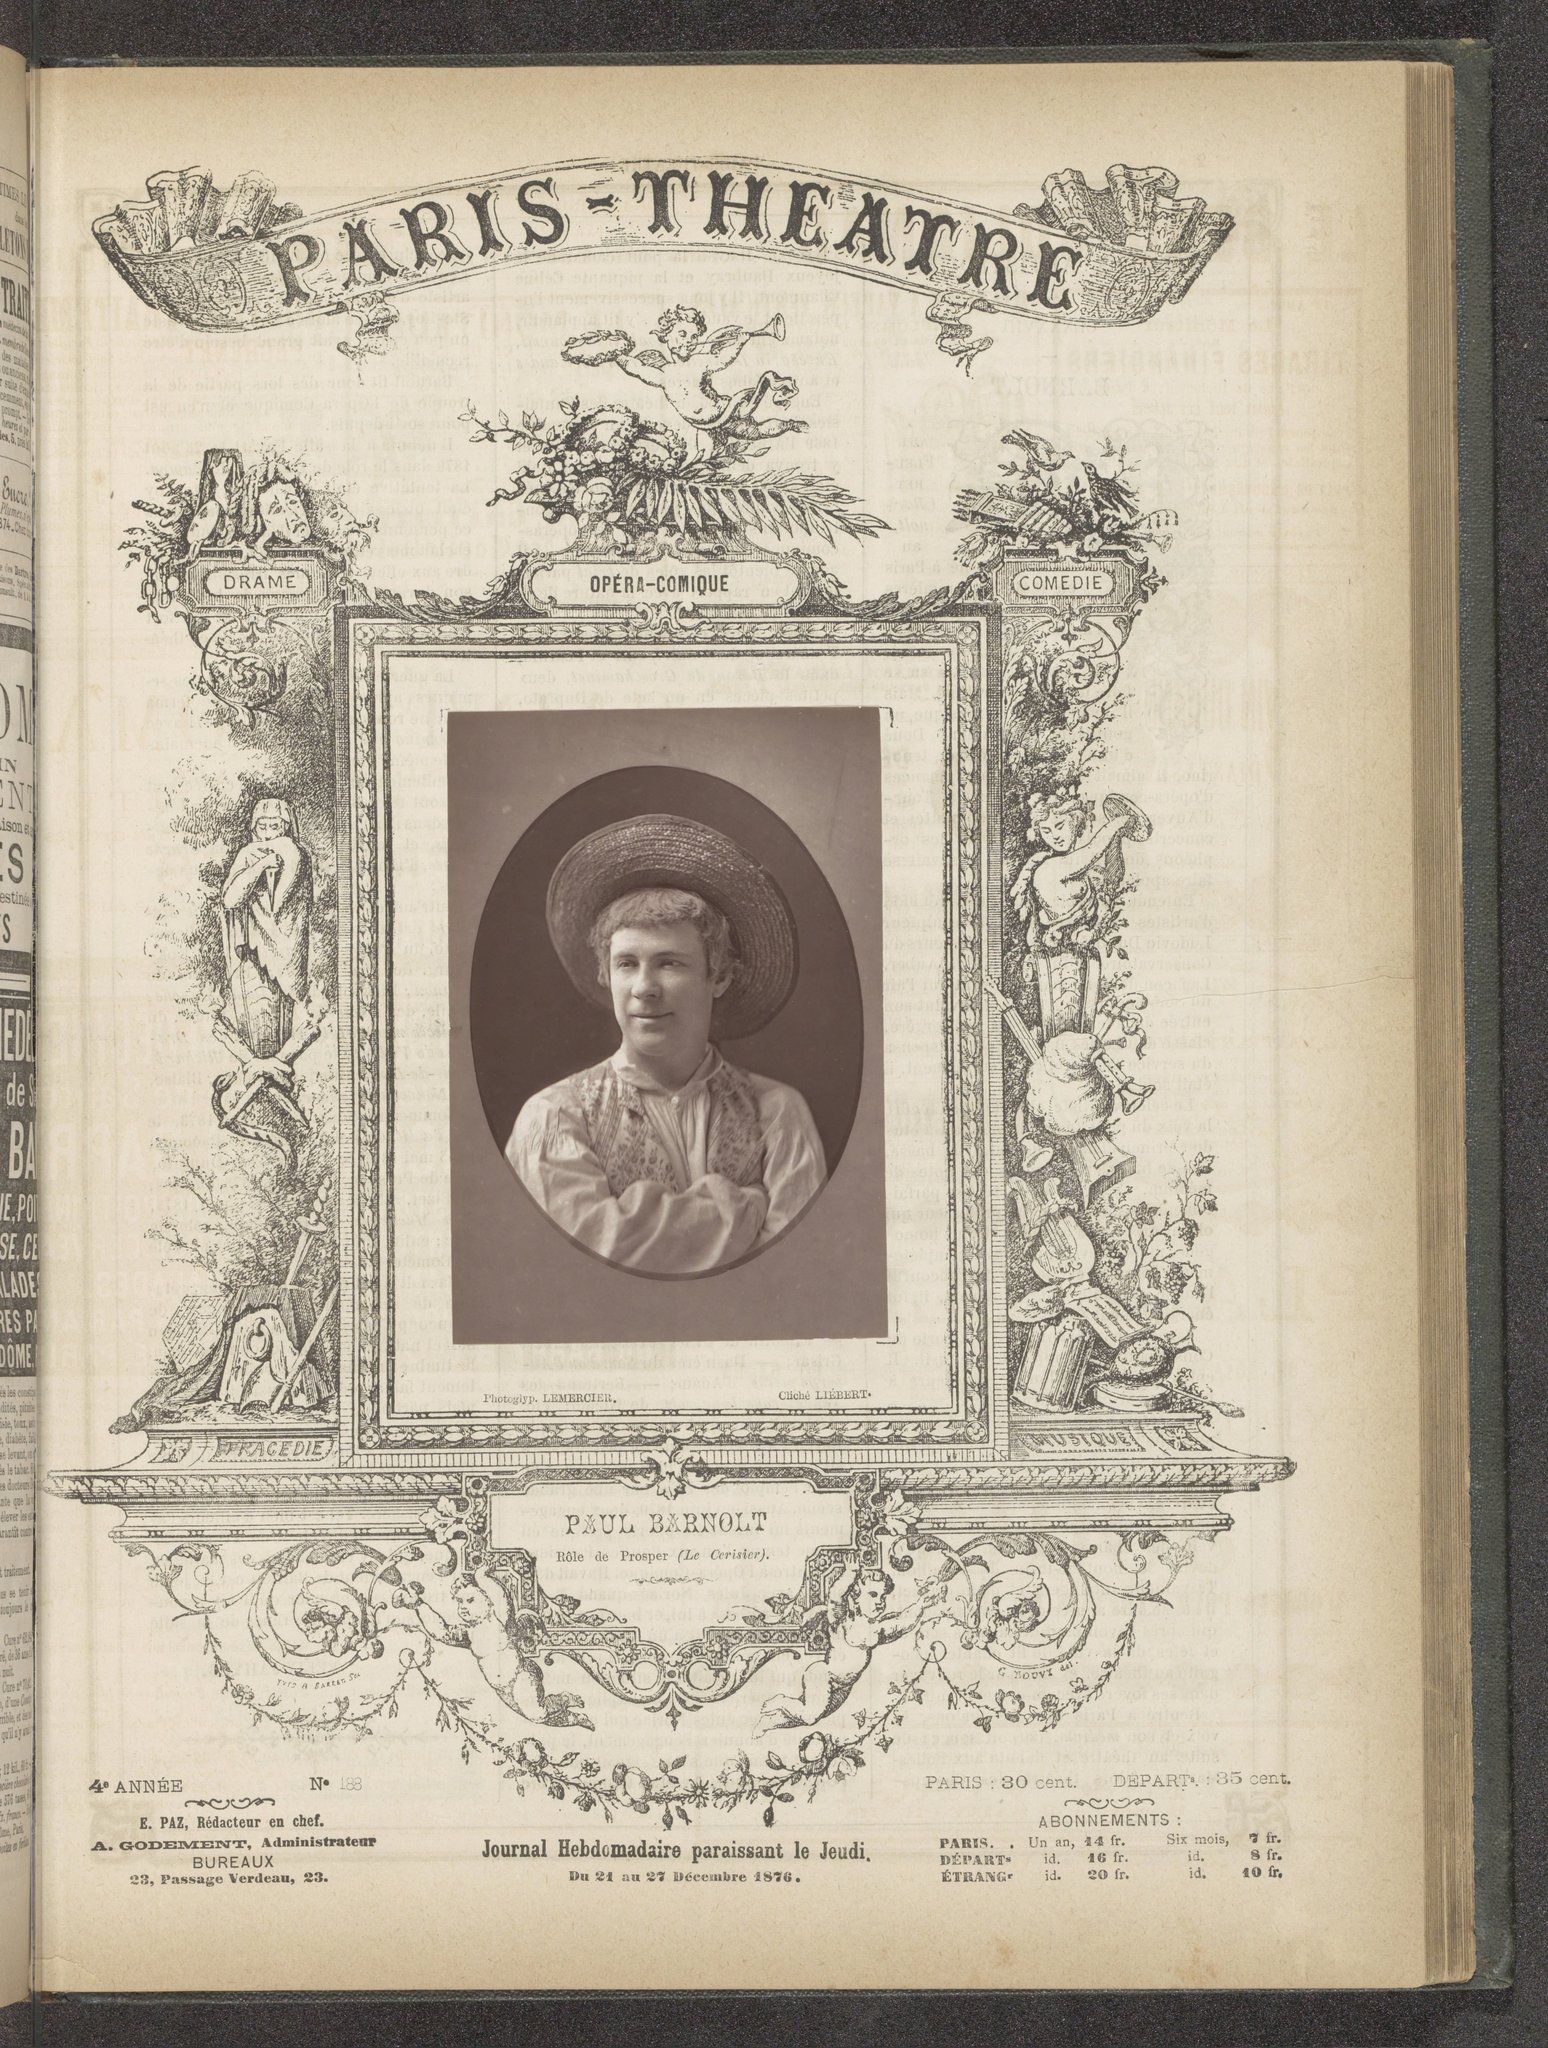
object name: page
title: Paul Barnolt rôle de Prosper (Le Cerisier)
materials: paper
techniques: woodburytype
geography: france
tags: portrait of opera-singer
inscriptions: number: ‘N 188’, inscription: ‘Journal hebdomadaire paraissant le Jeudi, Du 21 au 27 Décembre 1876.’